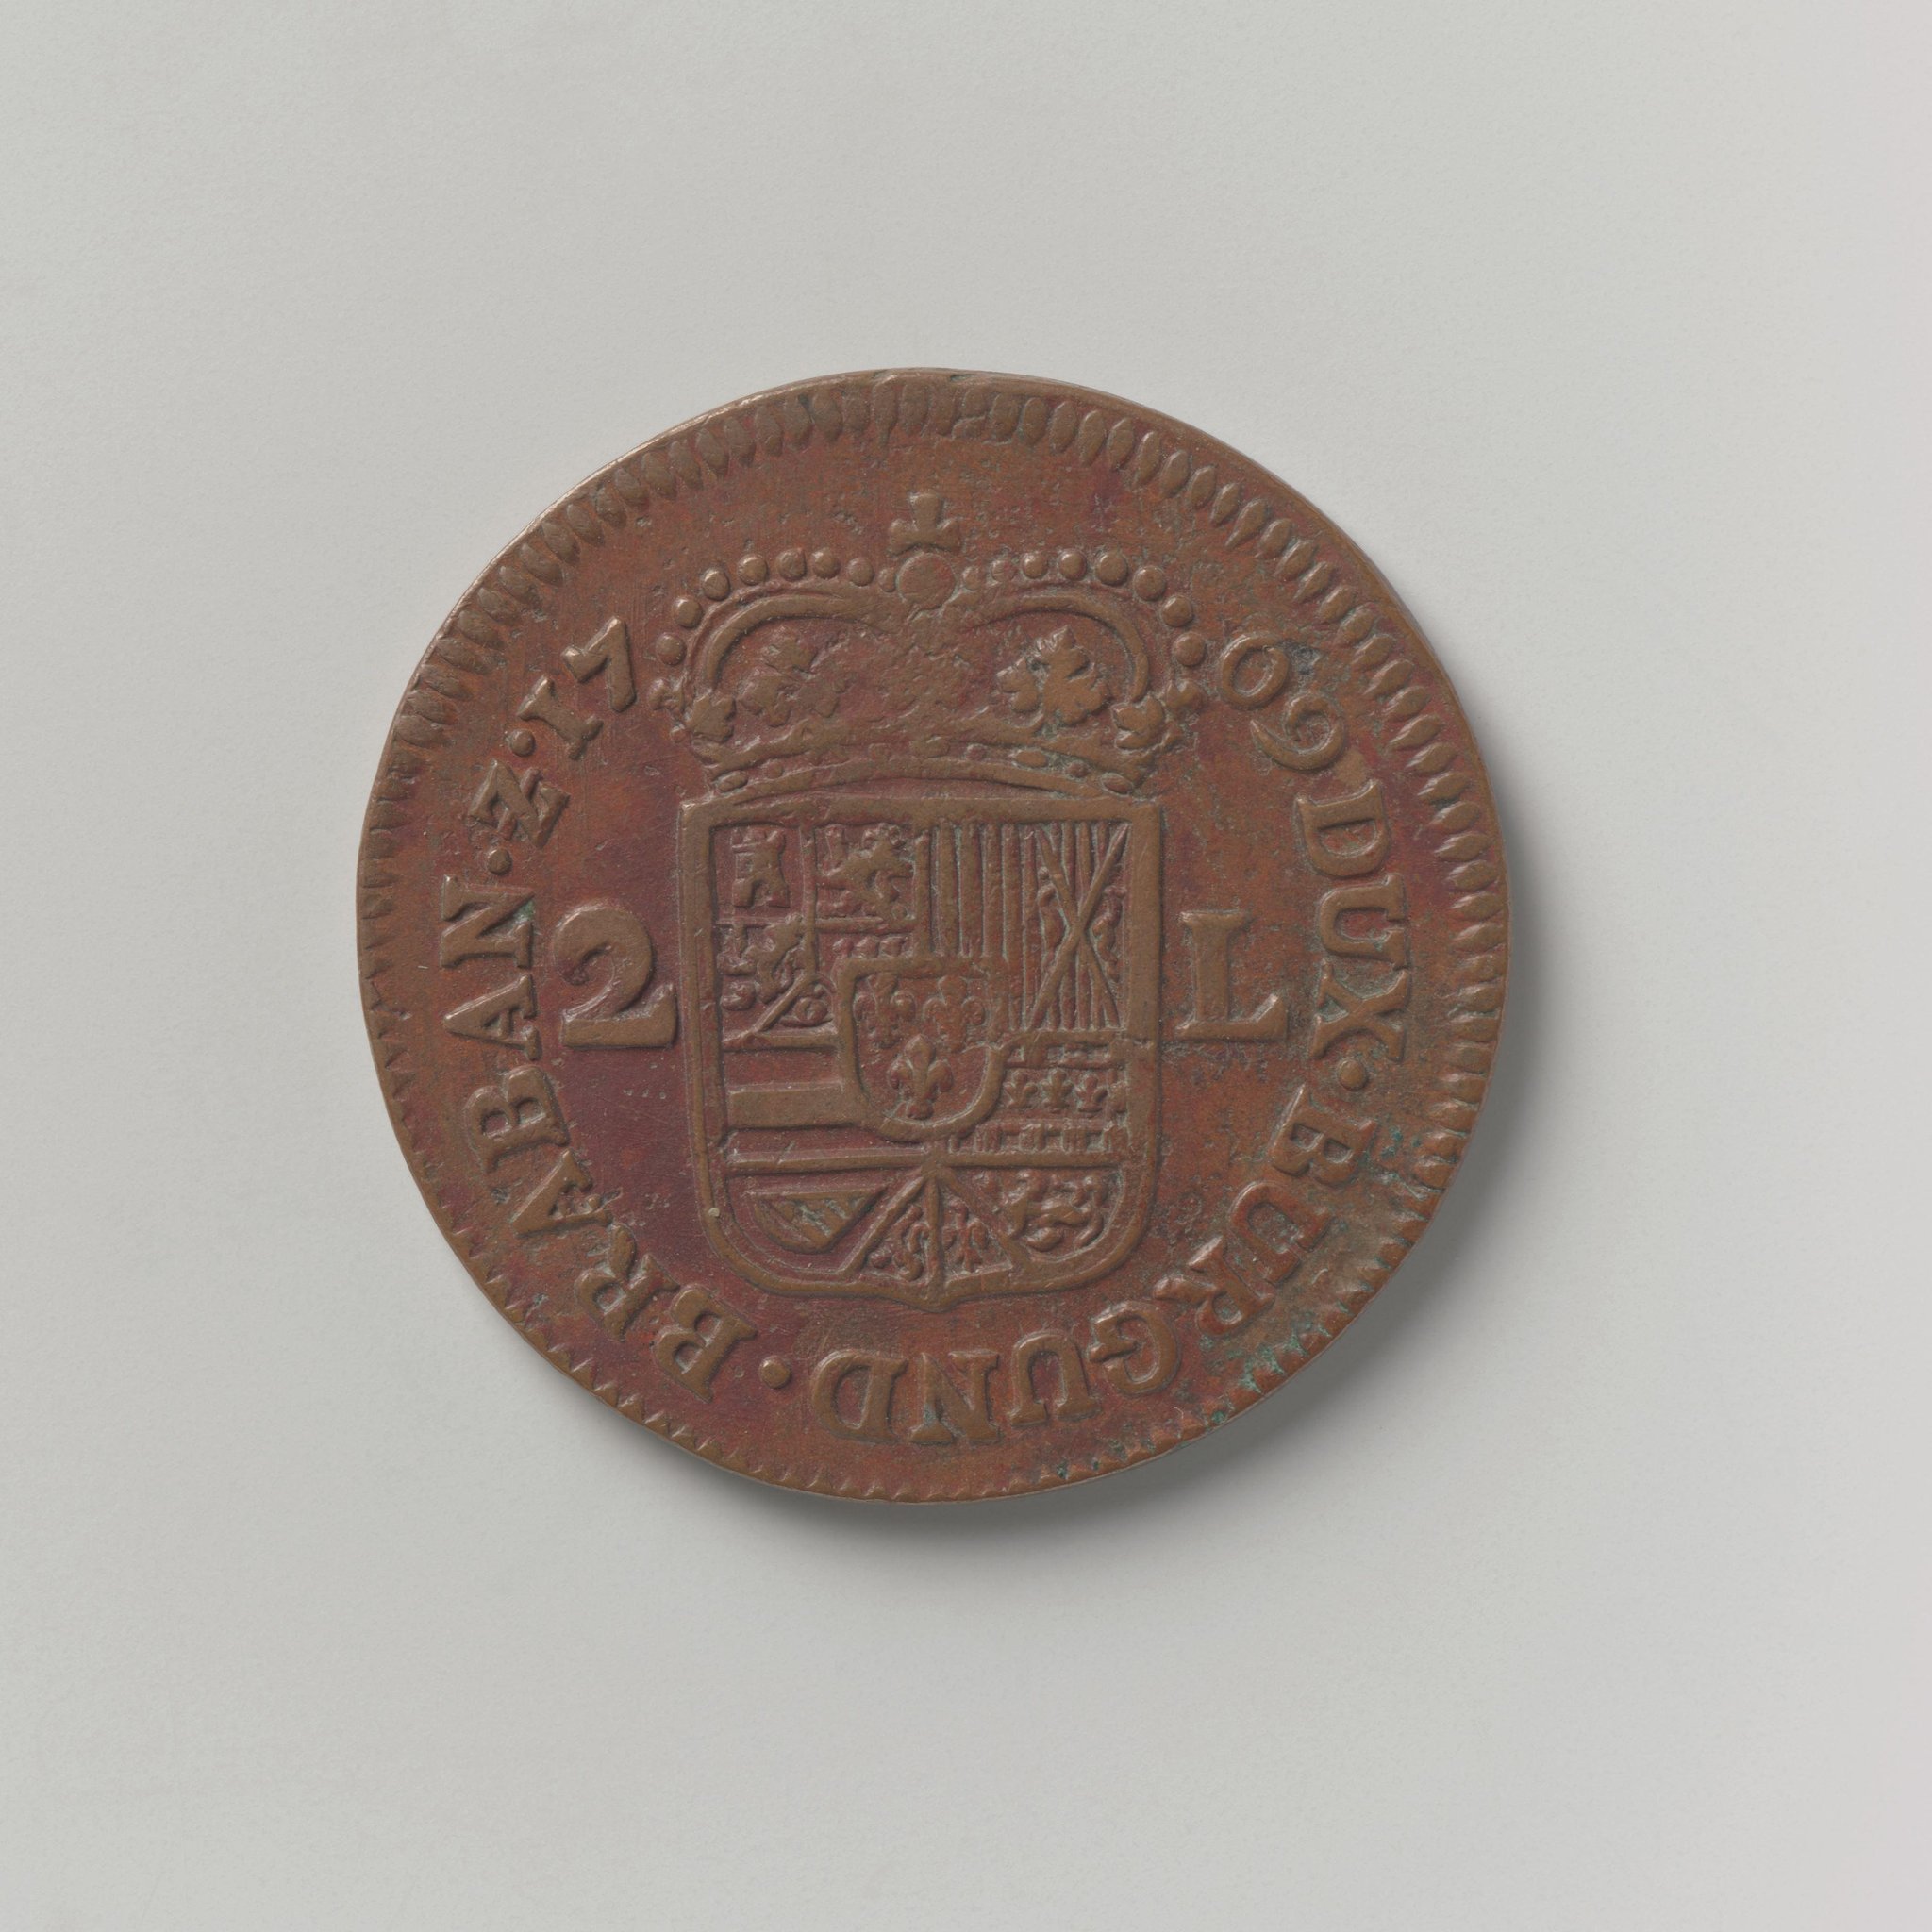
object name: coin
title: Dubbele oord uit Namen van Philips V, 1709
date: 1709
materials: copper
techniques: striking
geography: namur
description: Koperen munt. Voorzijde: portret van Philips V naar rechts. Leeuw onder portret. Keerzijde: tussen waarde-aaanduiding gekroond samengesteld wapenschild. Jaartal rondom kroon.